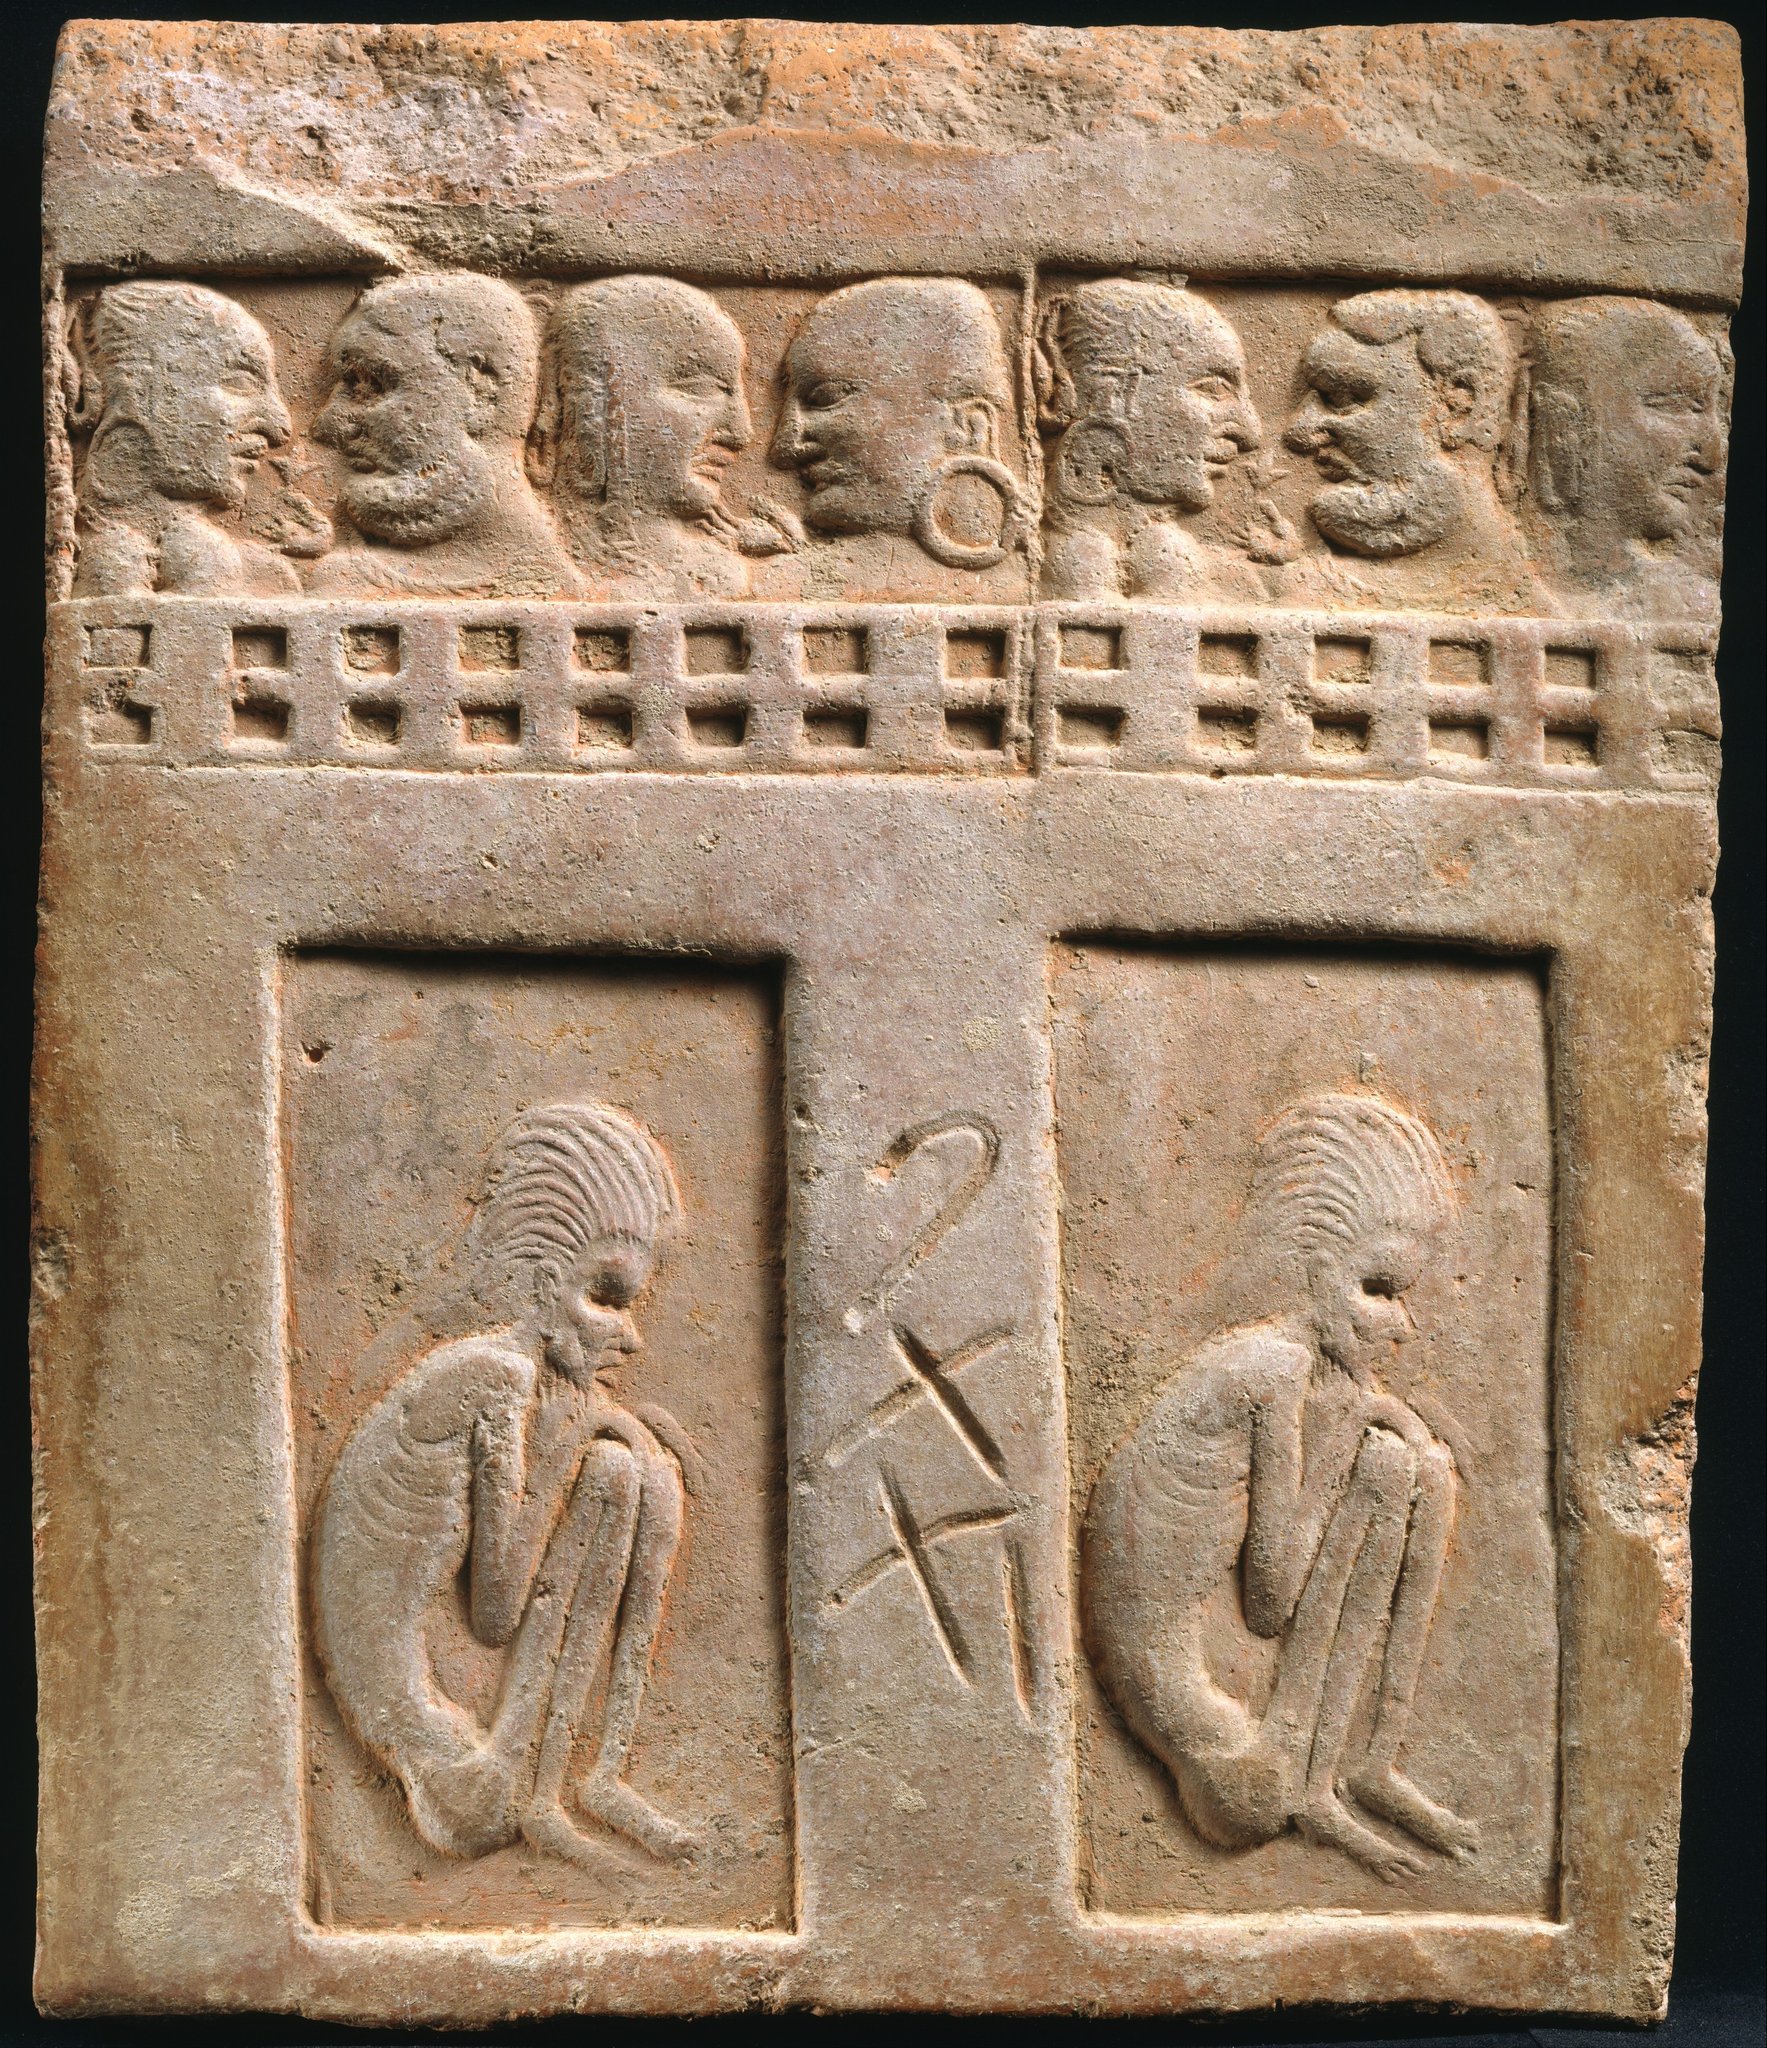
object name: tile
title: Tile with Impressed Figures of Emaciated Ascetics and Couples Behind Balconies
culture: india, kashmir, harwan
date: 401-600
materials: terracotta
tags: human figures,kashmir